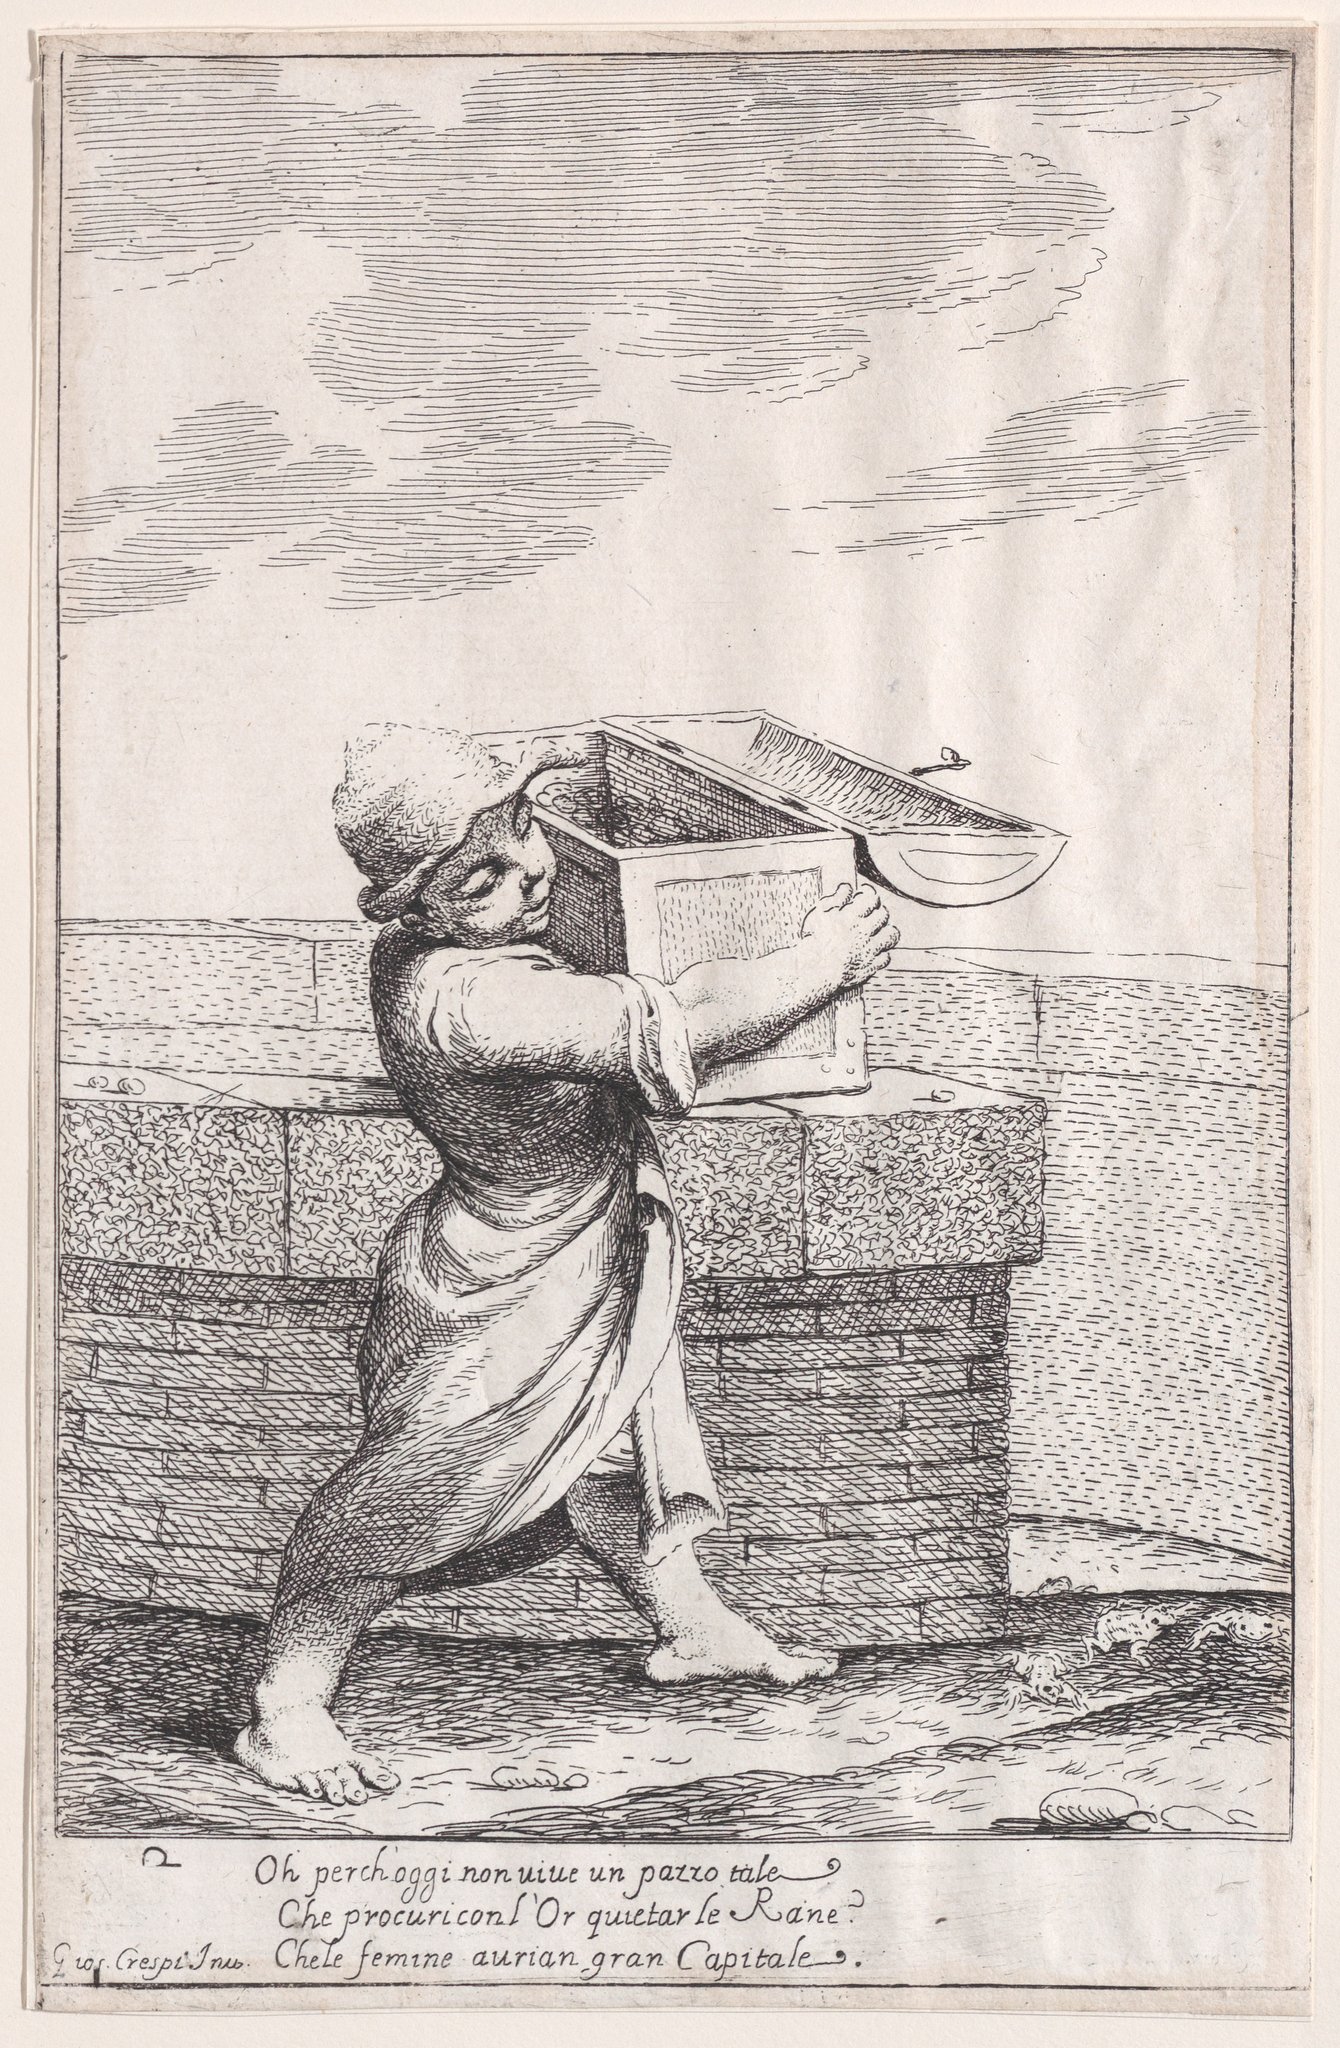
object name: print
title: Plate 8: Bertoldino, enraged by the croaking frogs, throws his strongbox into the fish pond, from "Bertoldo, Bertoldino, and Cacasenno"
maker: giuseppe maria crespi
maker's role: artist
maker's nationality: italian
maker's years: 1665-1747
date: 1705-1715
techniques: etching